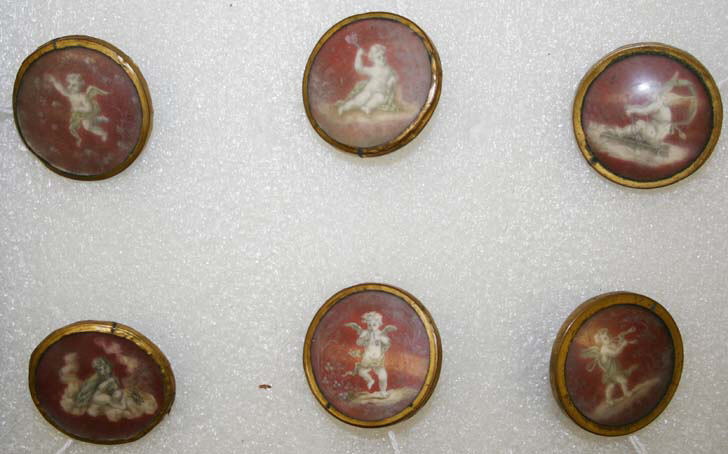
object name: button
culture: french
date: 1775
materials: glass, ivory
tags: putti